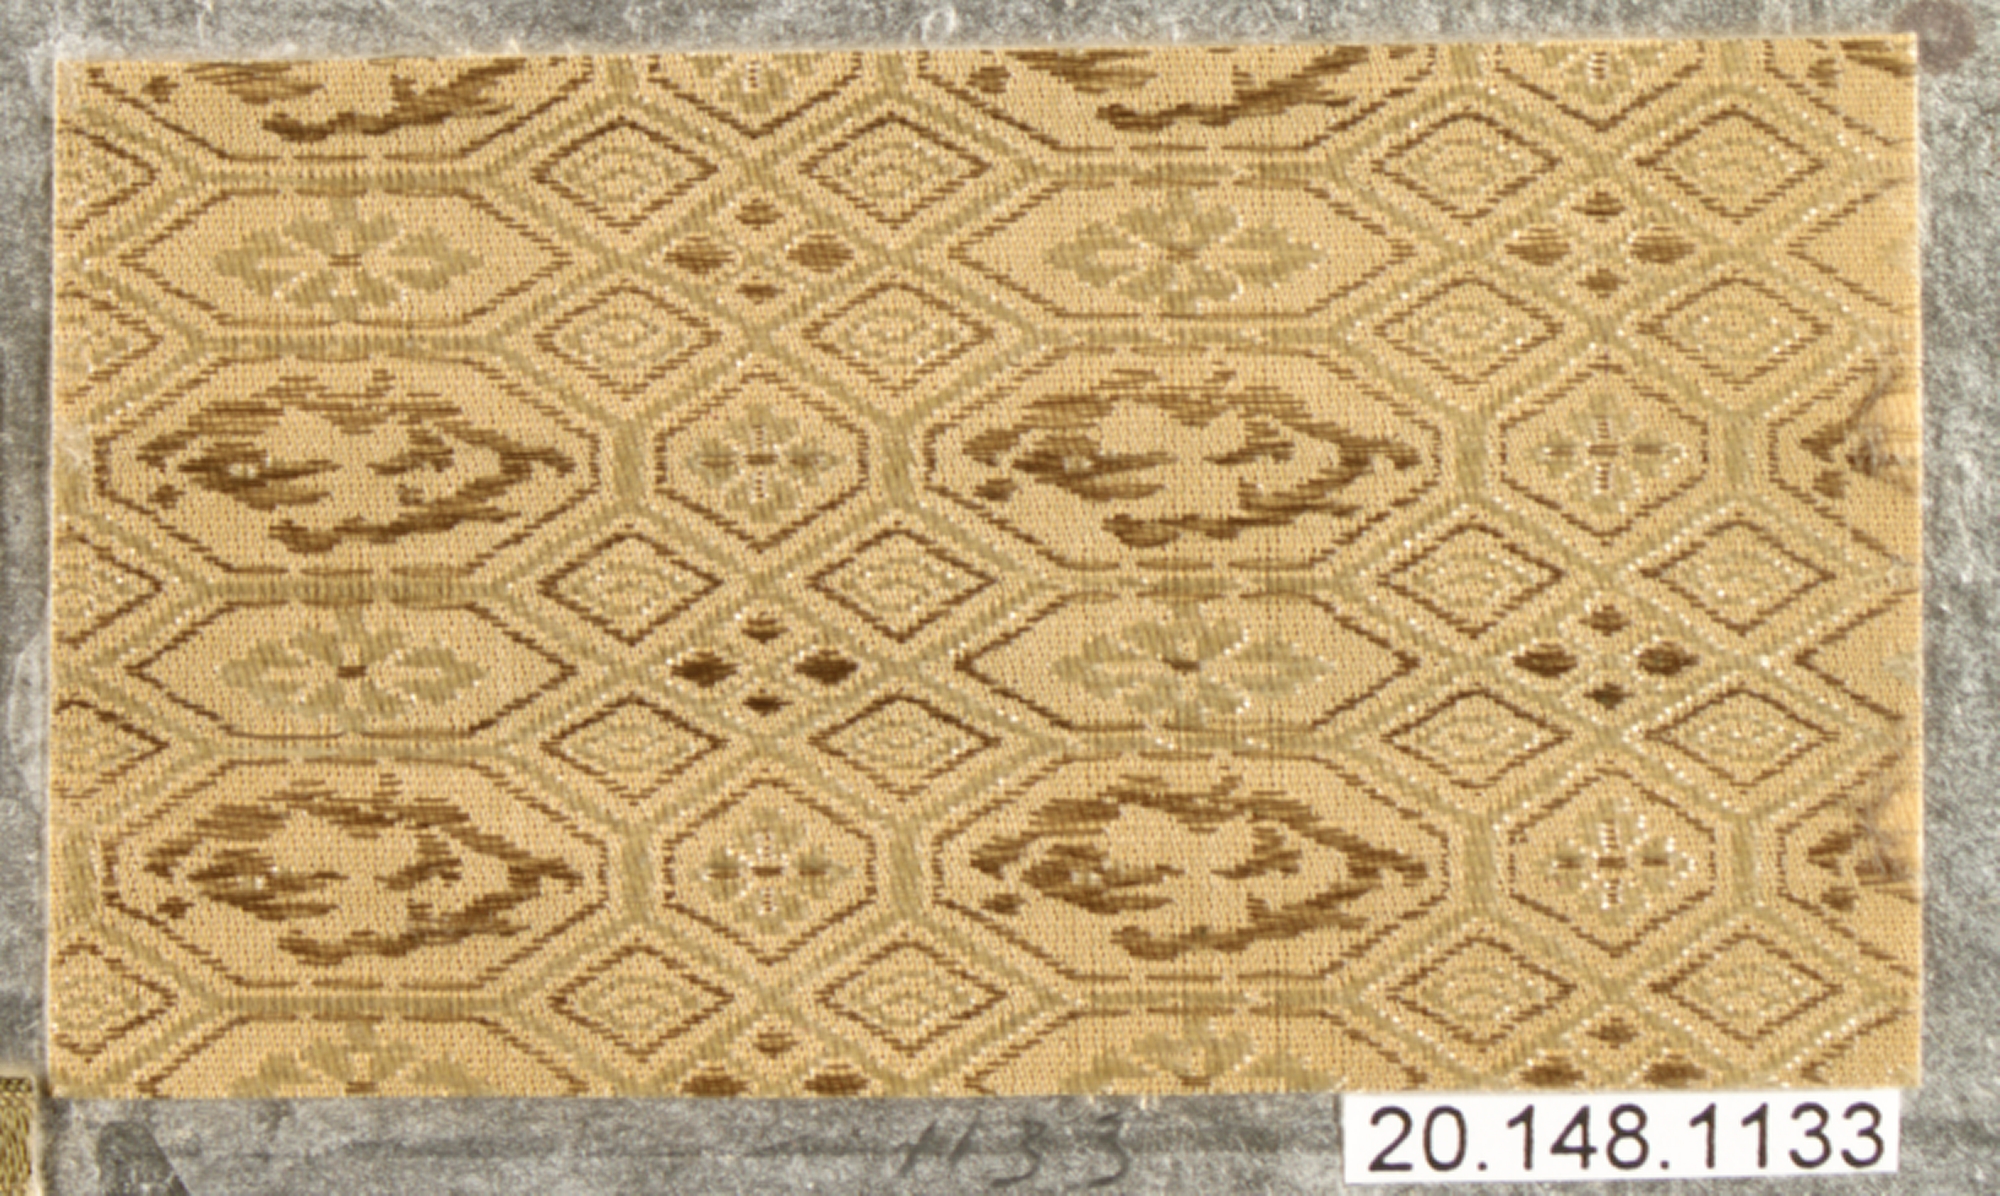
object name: piece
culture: japanese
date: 1801-1900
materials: silk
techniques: compound weave